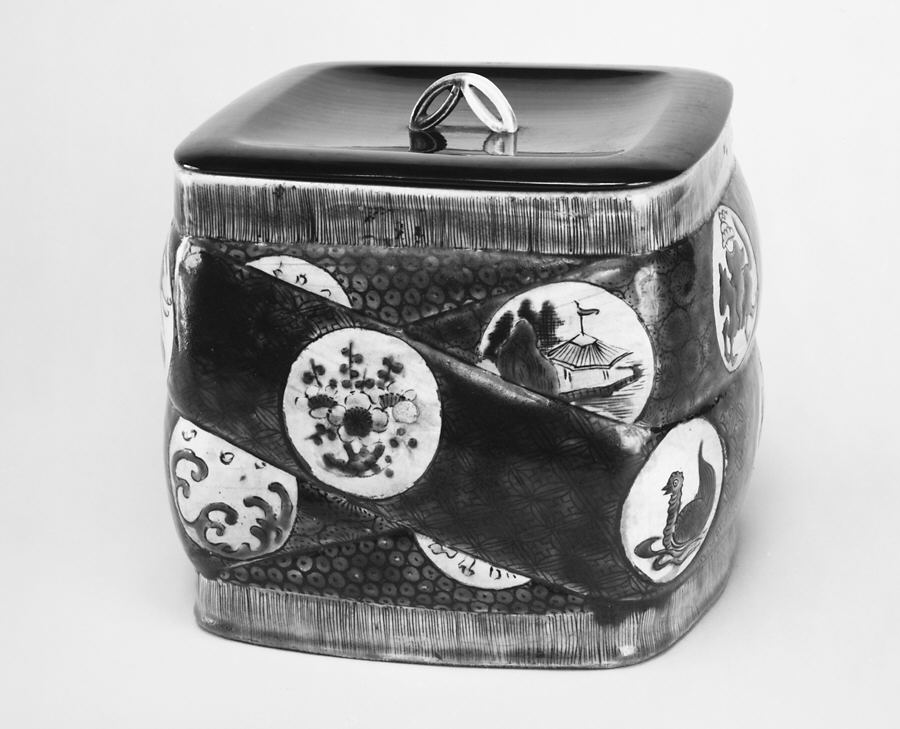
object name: water jar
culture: japanese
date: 1801-1900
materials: enamel, lacquer, porcelain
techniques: polychrome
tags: animals,flowers,leaves